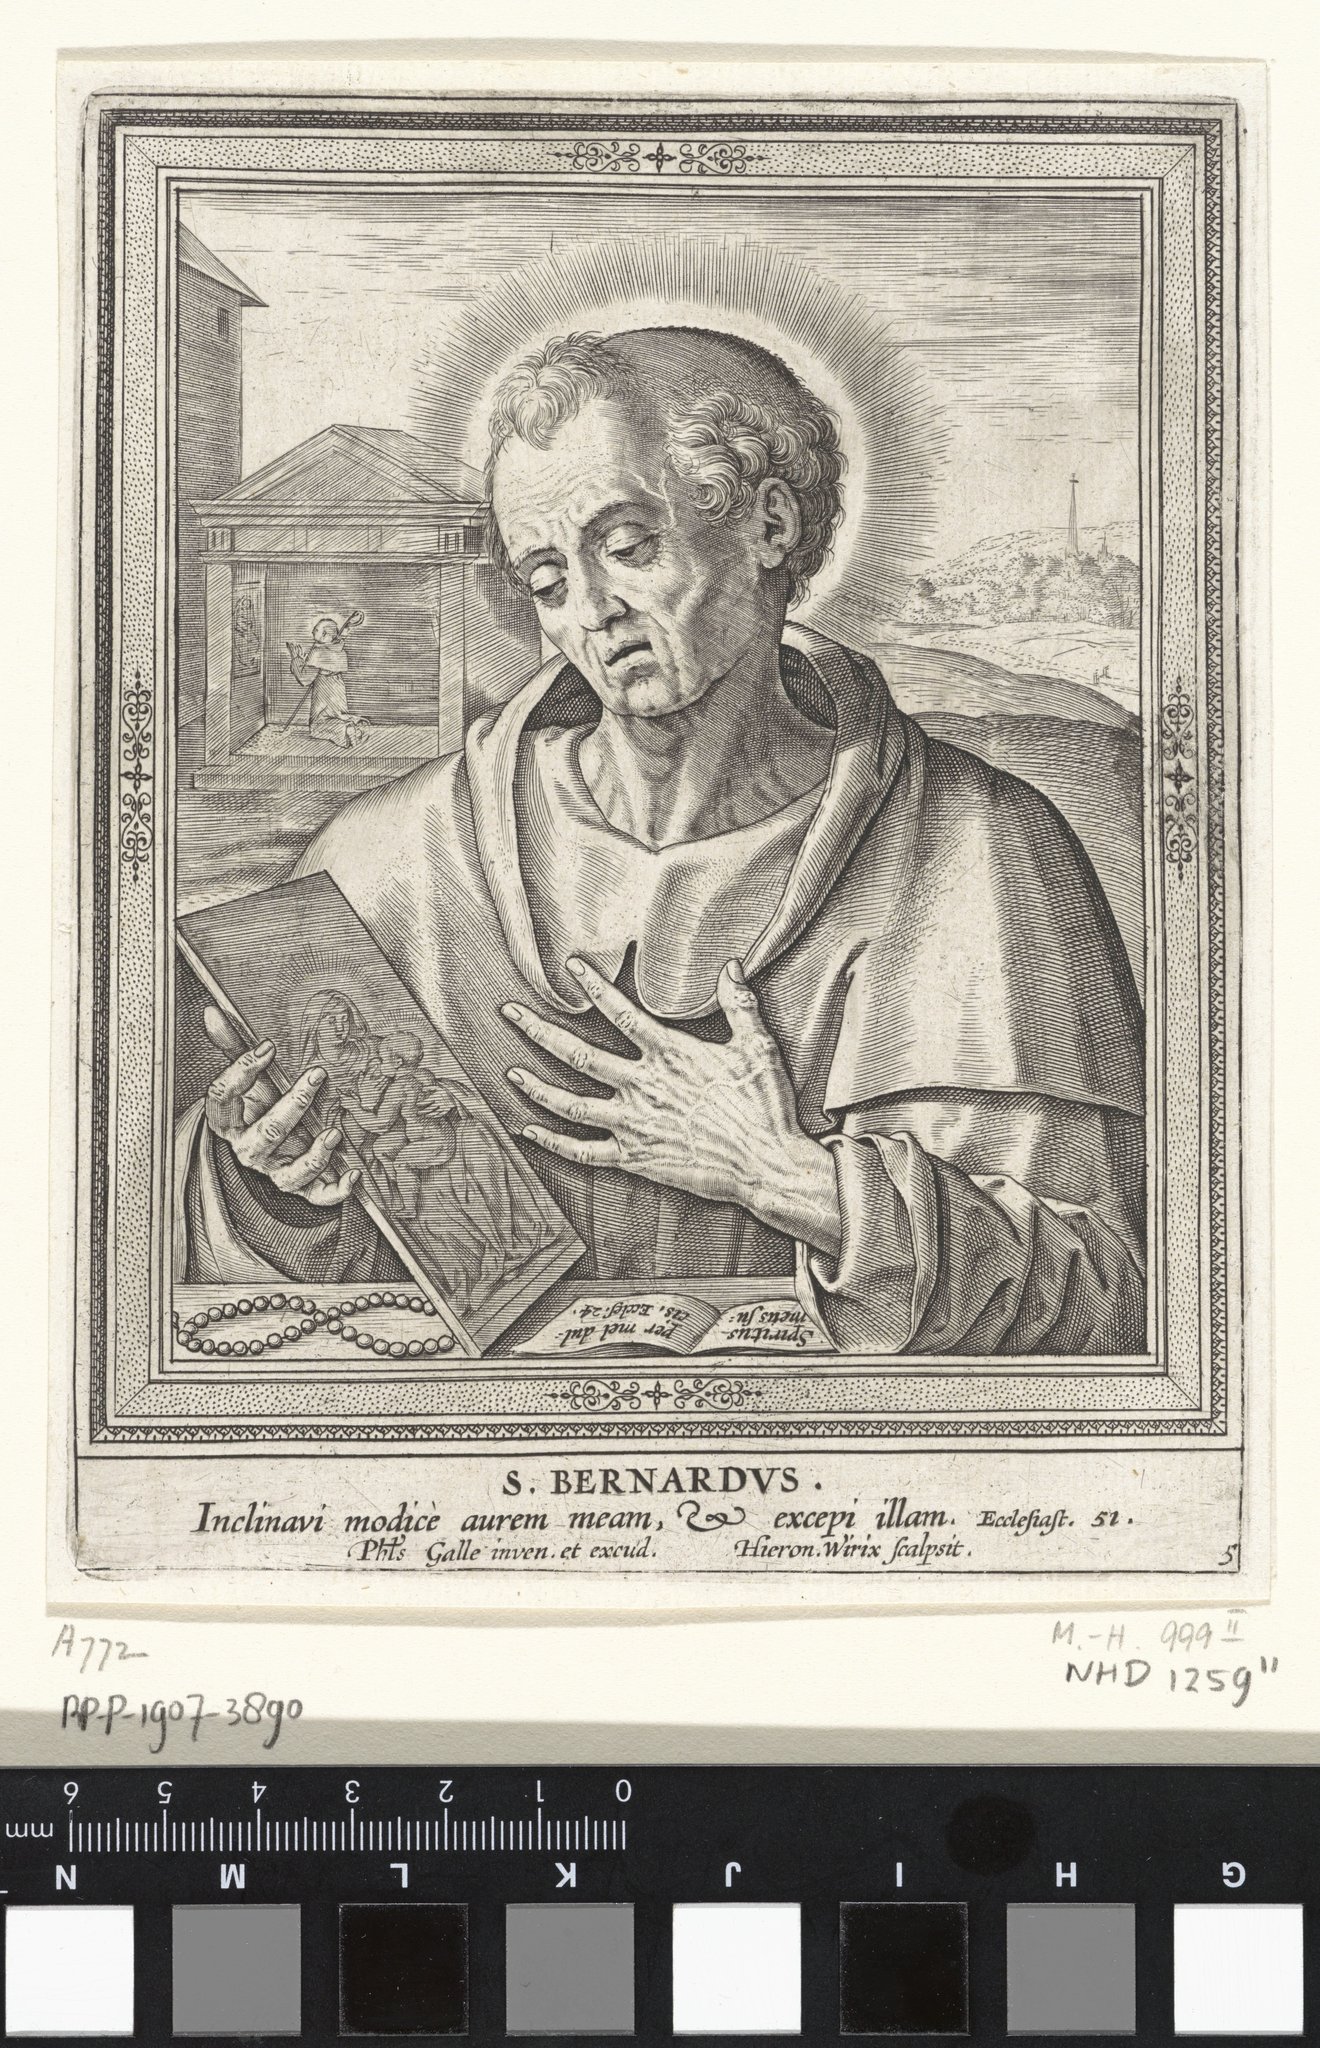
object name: print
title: S. Bernardvs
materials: paper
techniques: engraving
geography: antwerp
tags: personal devotion of st. bernard of st. bernard of clairvaux - male saint meditating, in ecstasy, bernard of clairvaux, cistercian monk and abbot; possible attributes: beehive, chained dragon, crucifix, cross with instruments of the passion, (three) mitre at his feet, white dog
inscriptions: collector's mark: Lugt 2542, collector's mark: Lugt 2228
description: De heilige Bernardus van Clairvaux, stichter van de orde van de cisterciënzers, met een afbeelding van Maria met het Christuskind in zijn handen. Links op de achtergrond knielt de heilige in een kapel voor een afbeelding van Maria en het Christuskind. In de marge een Bijbelcitaat uit Sir. 51 in het Latijn.